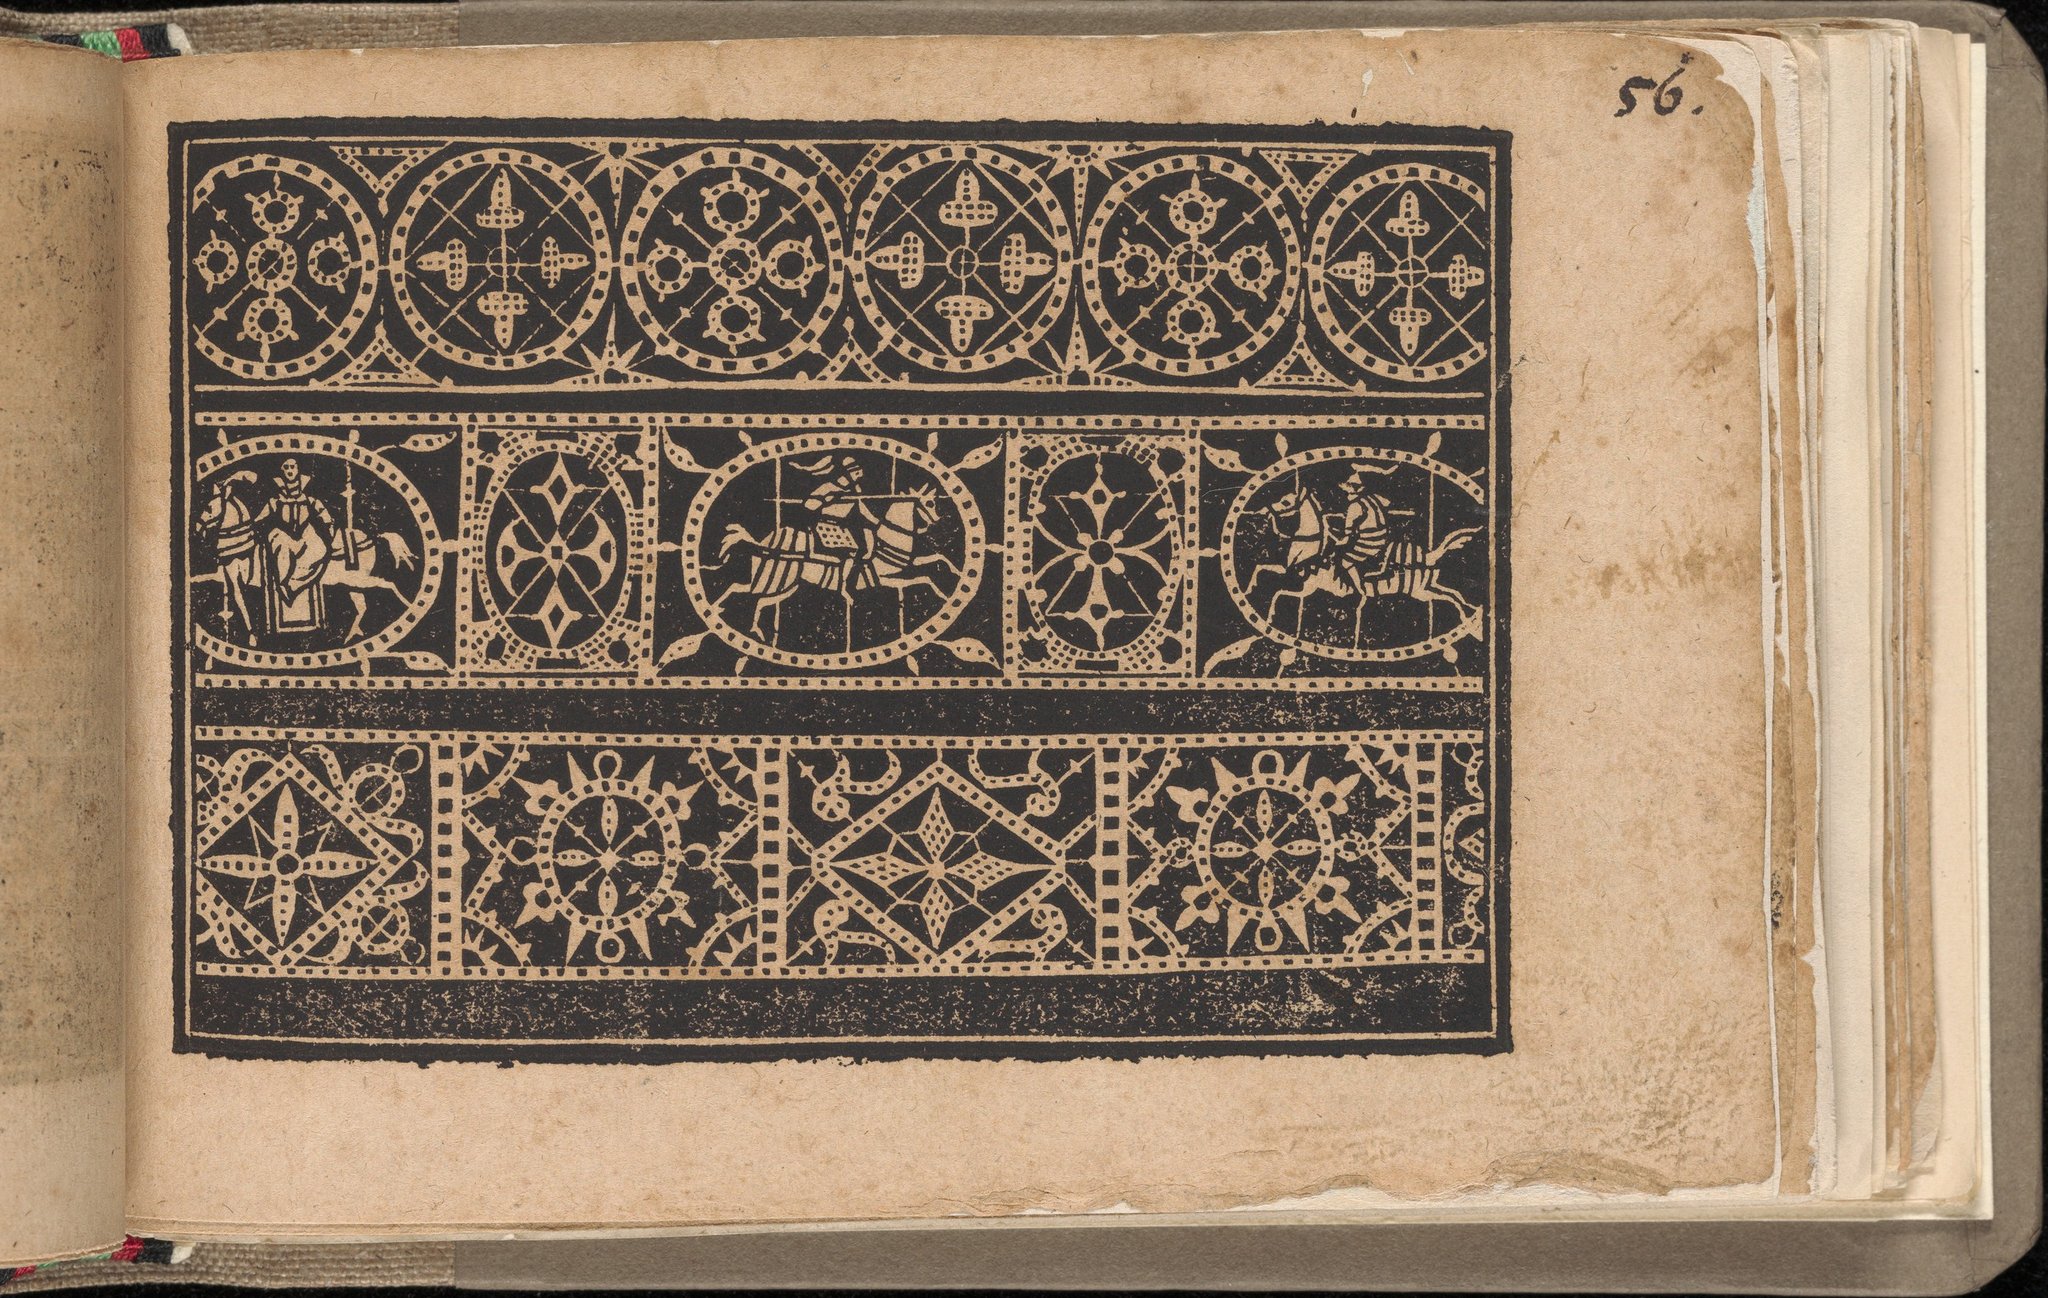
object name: book print ornament architecture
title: Schön newes Modelbuch (Page 56r)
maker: sigismundus latomus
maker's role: publisher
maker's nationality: german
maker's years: 1599-1632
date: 1608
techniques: woodcut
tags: ornament